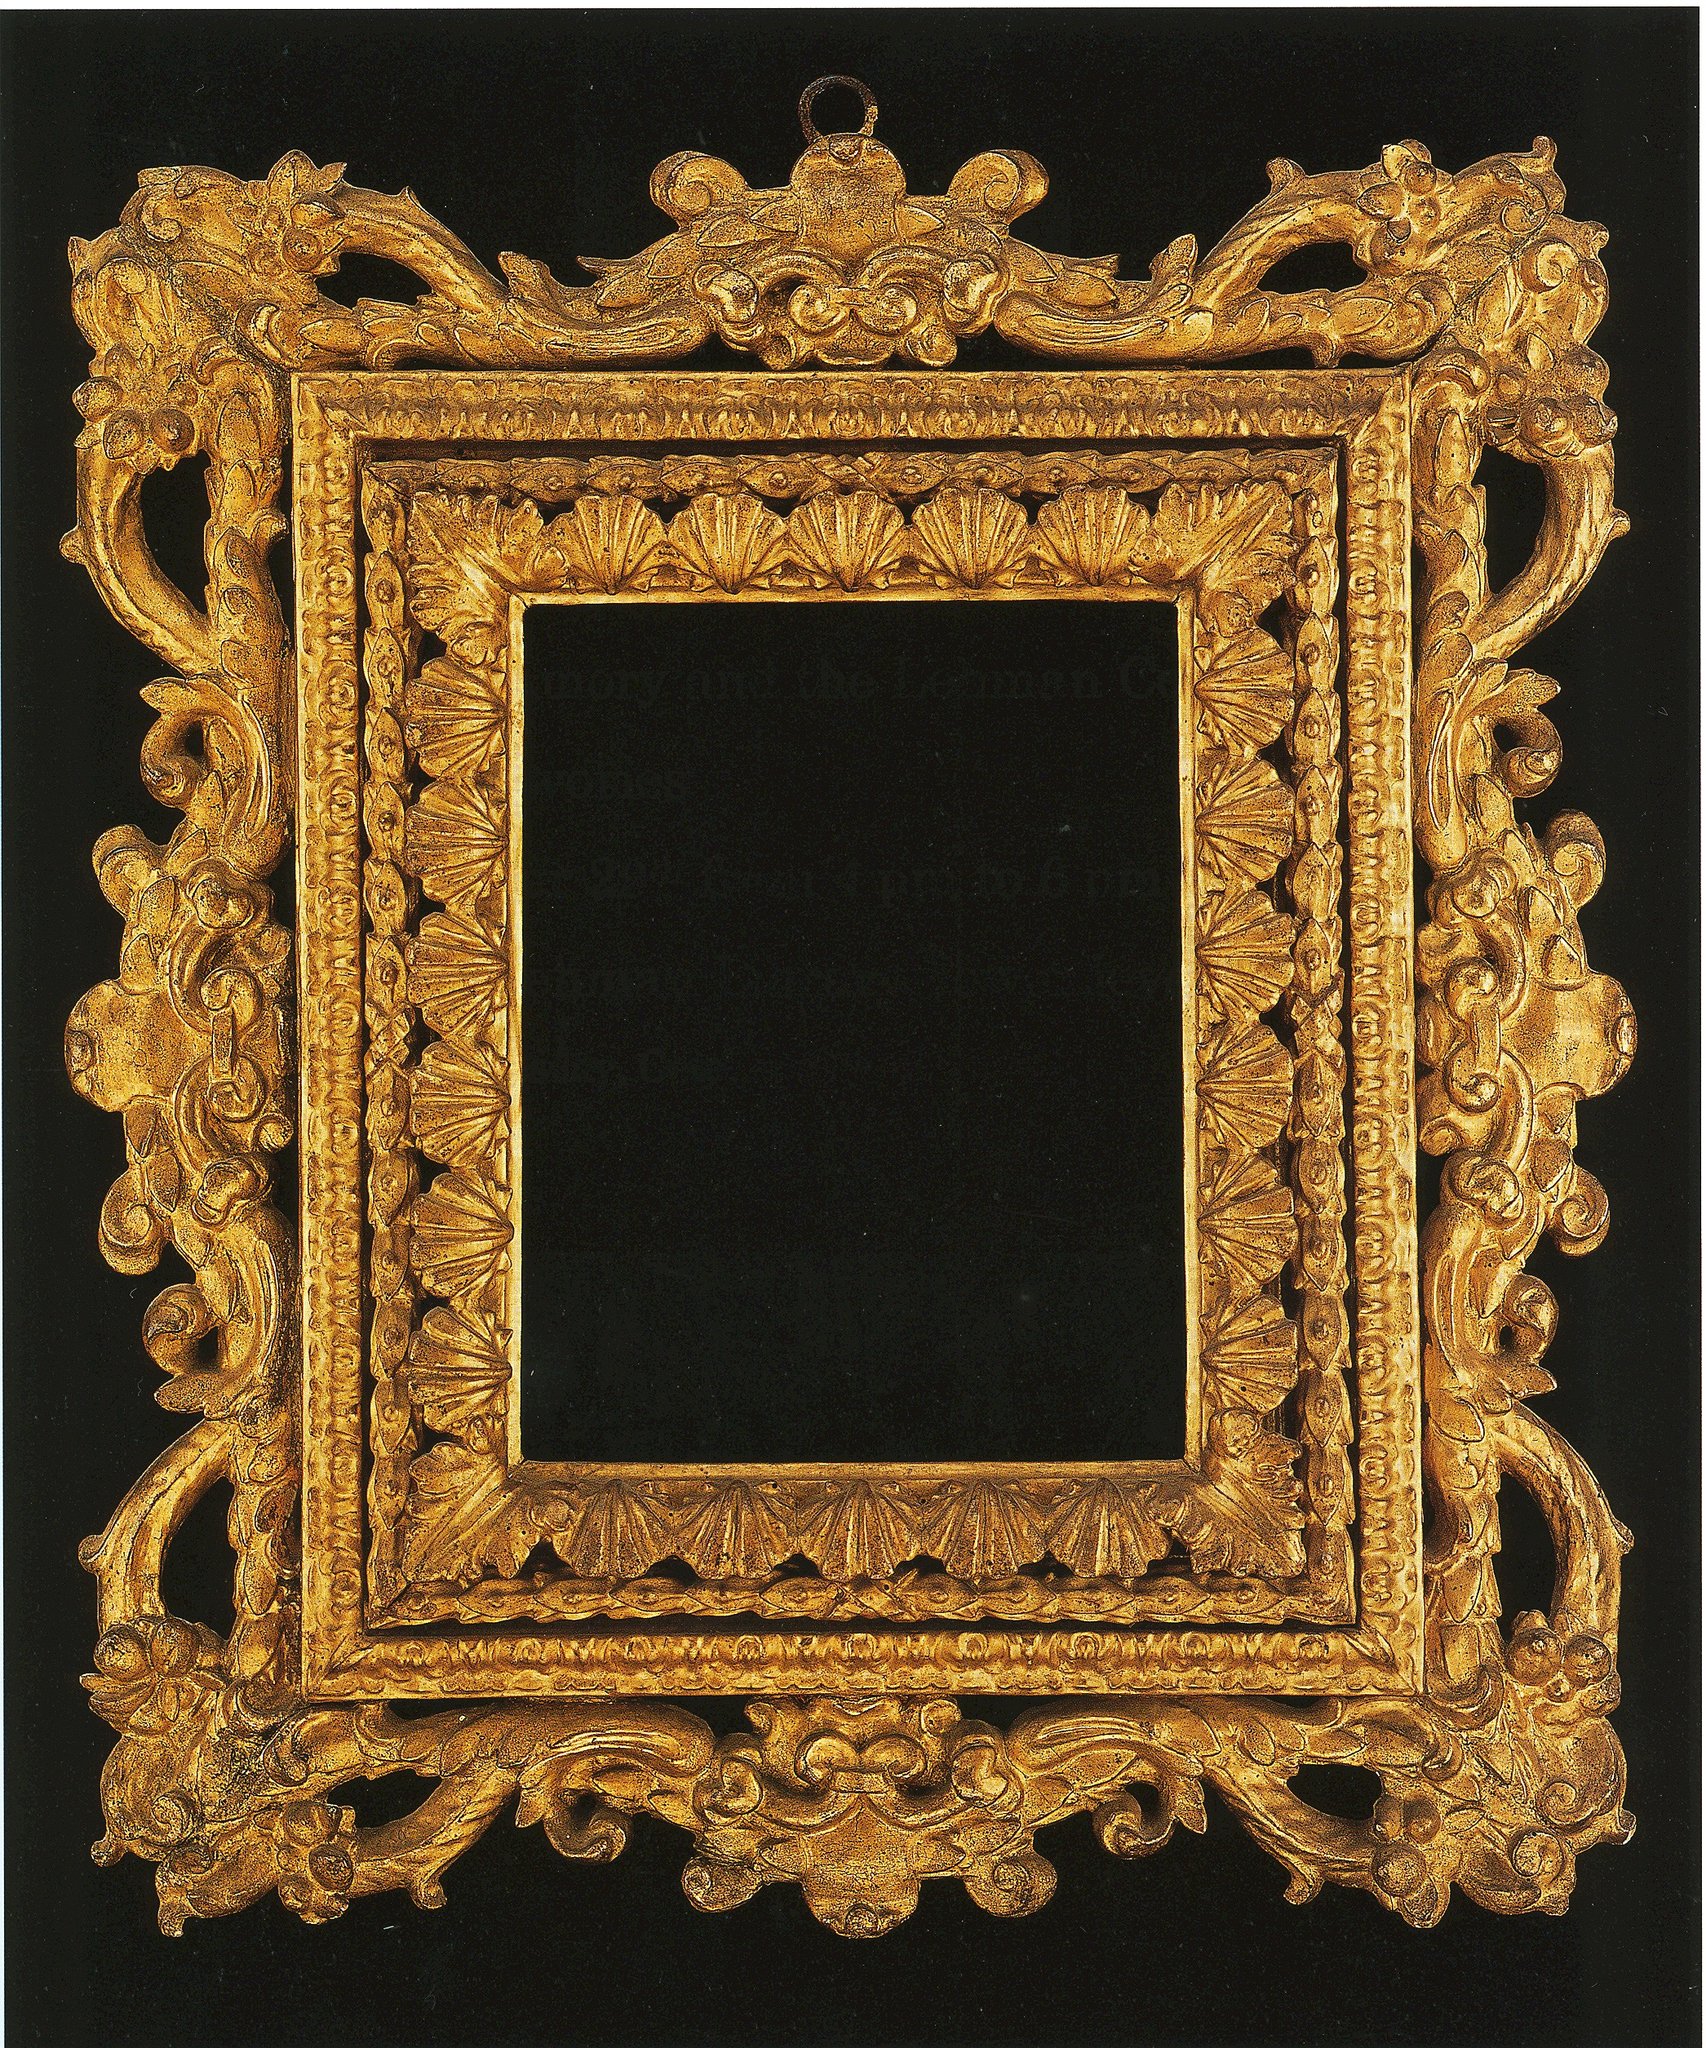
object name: frame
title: Reverse frame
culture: southern italian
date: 1701-1733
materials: wood